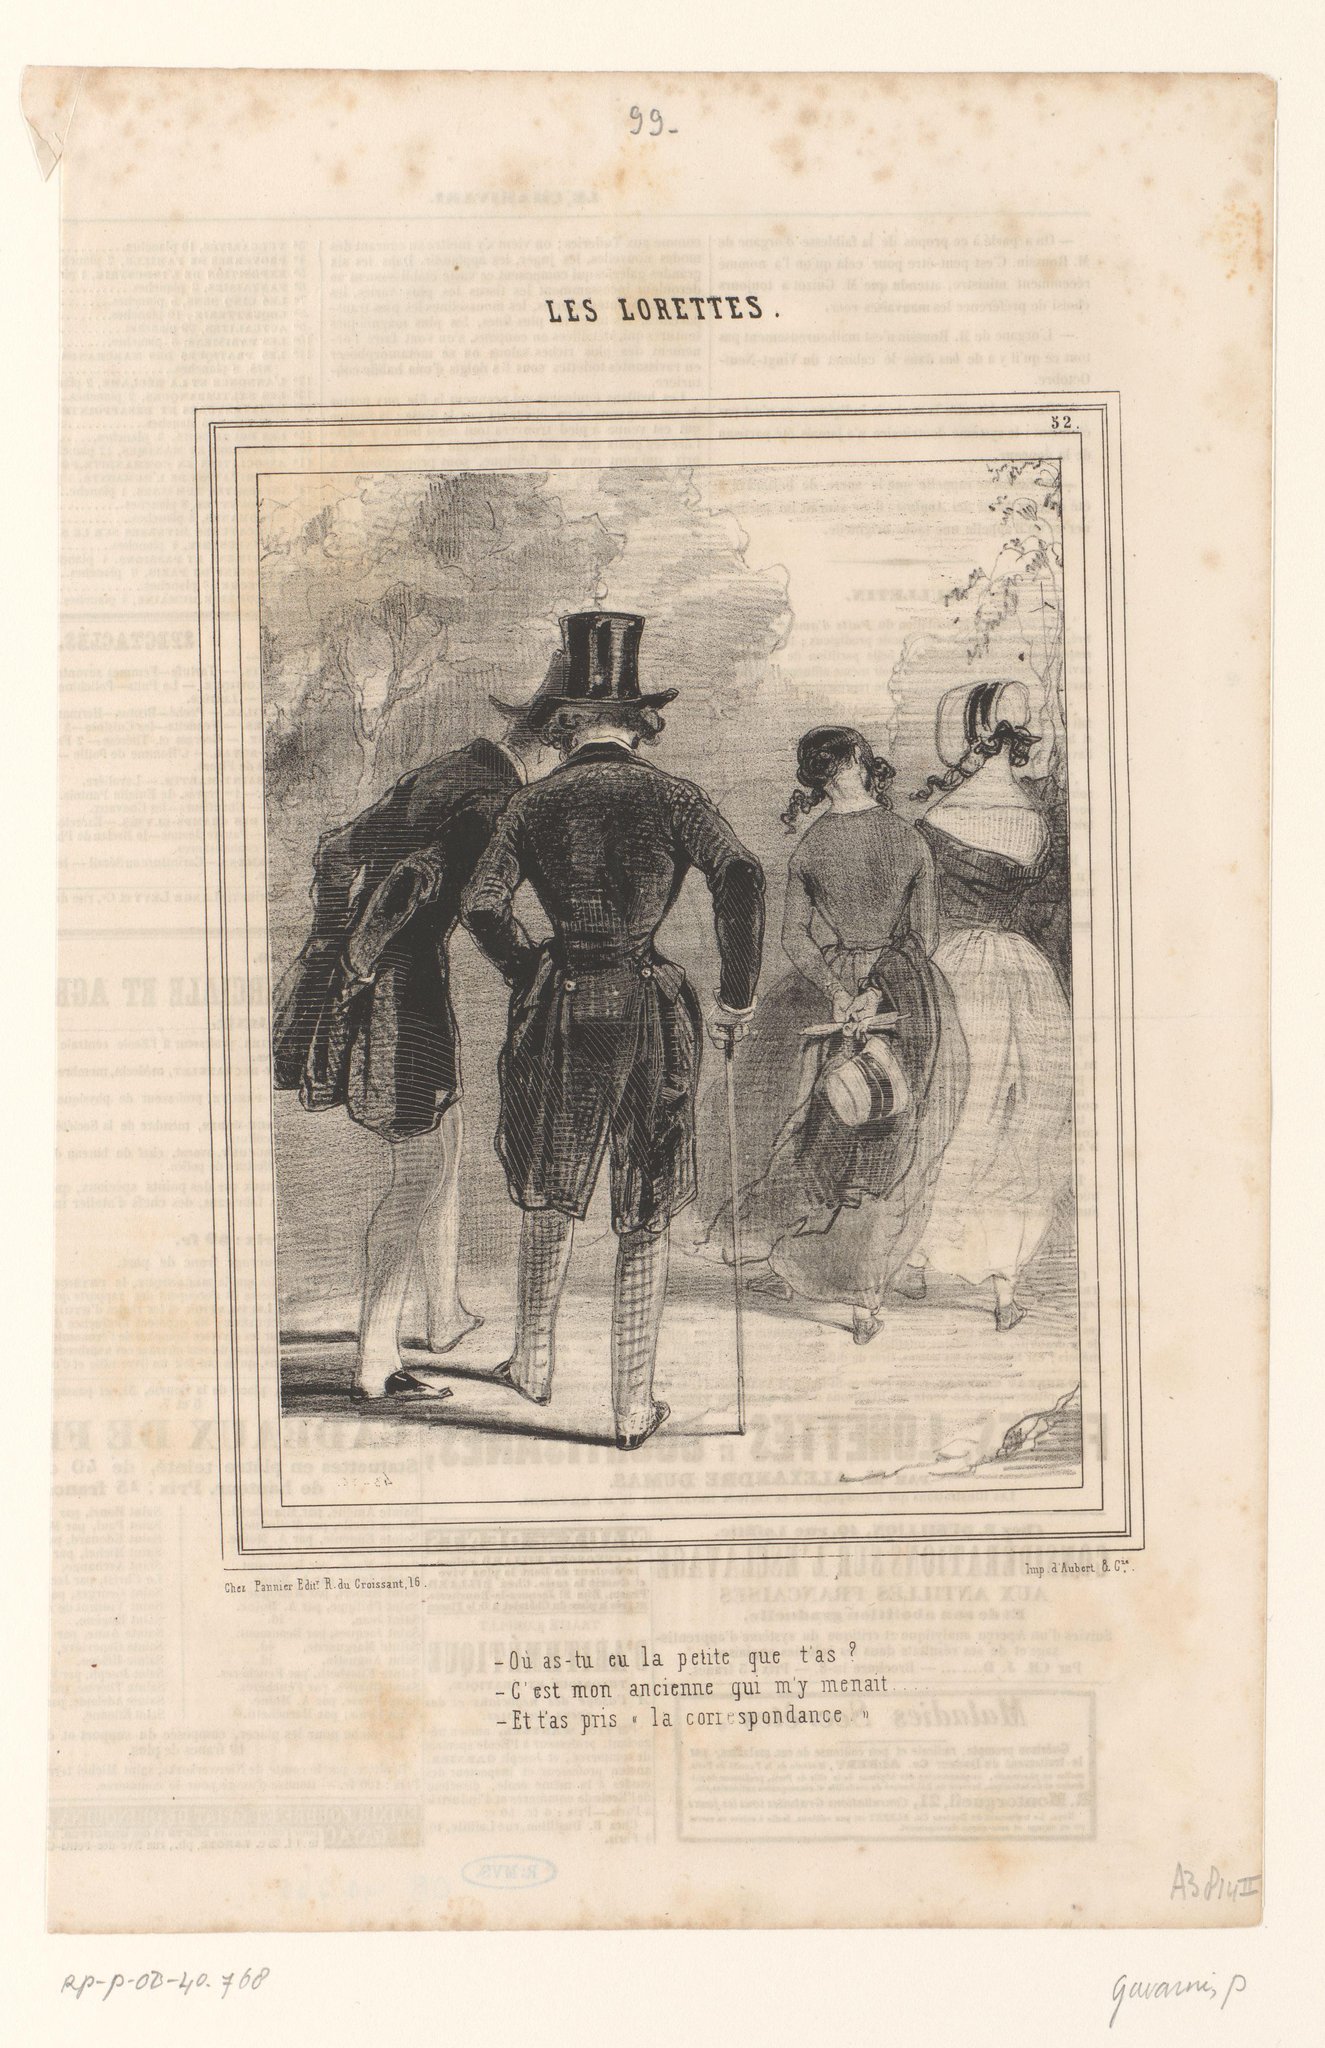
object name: print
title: Twee vrouwen wandelen, gevolgd door hun minnaars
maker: paul gavarni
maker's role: draughtsman, print maker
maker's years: 1804-1866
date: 1843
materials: paper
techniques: lithograph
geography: paris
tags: walking, hiking (recreation), lovers' meeting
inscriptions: collector's mark: Lugt 2228a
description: Prent gebruikt voor: Le Charivari, 18 mei 1843.